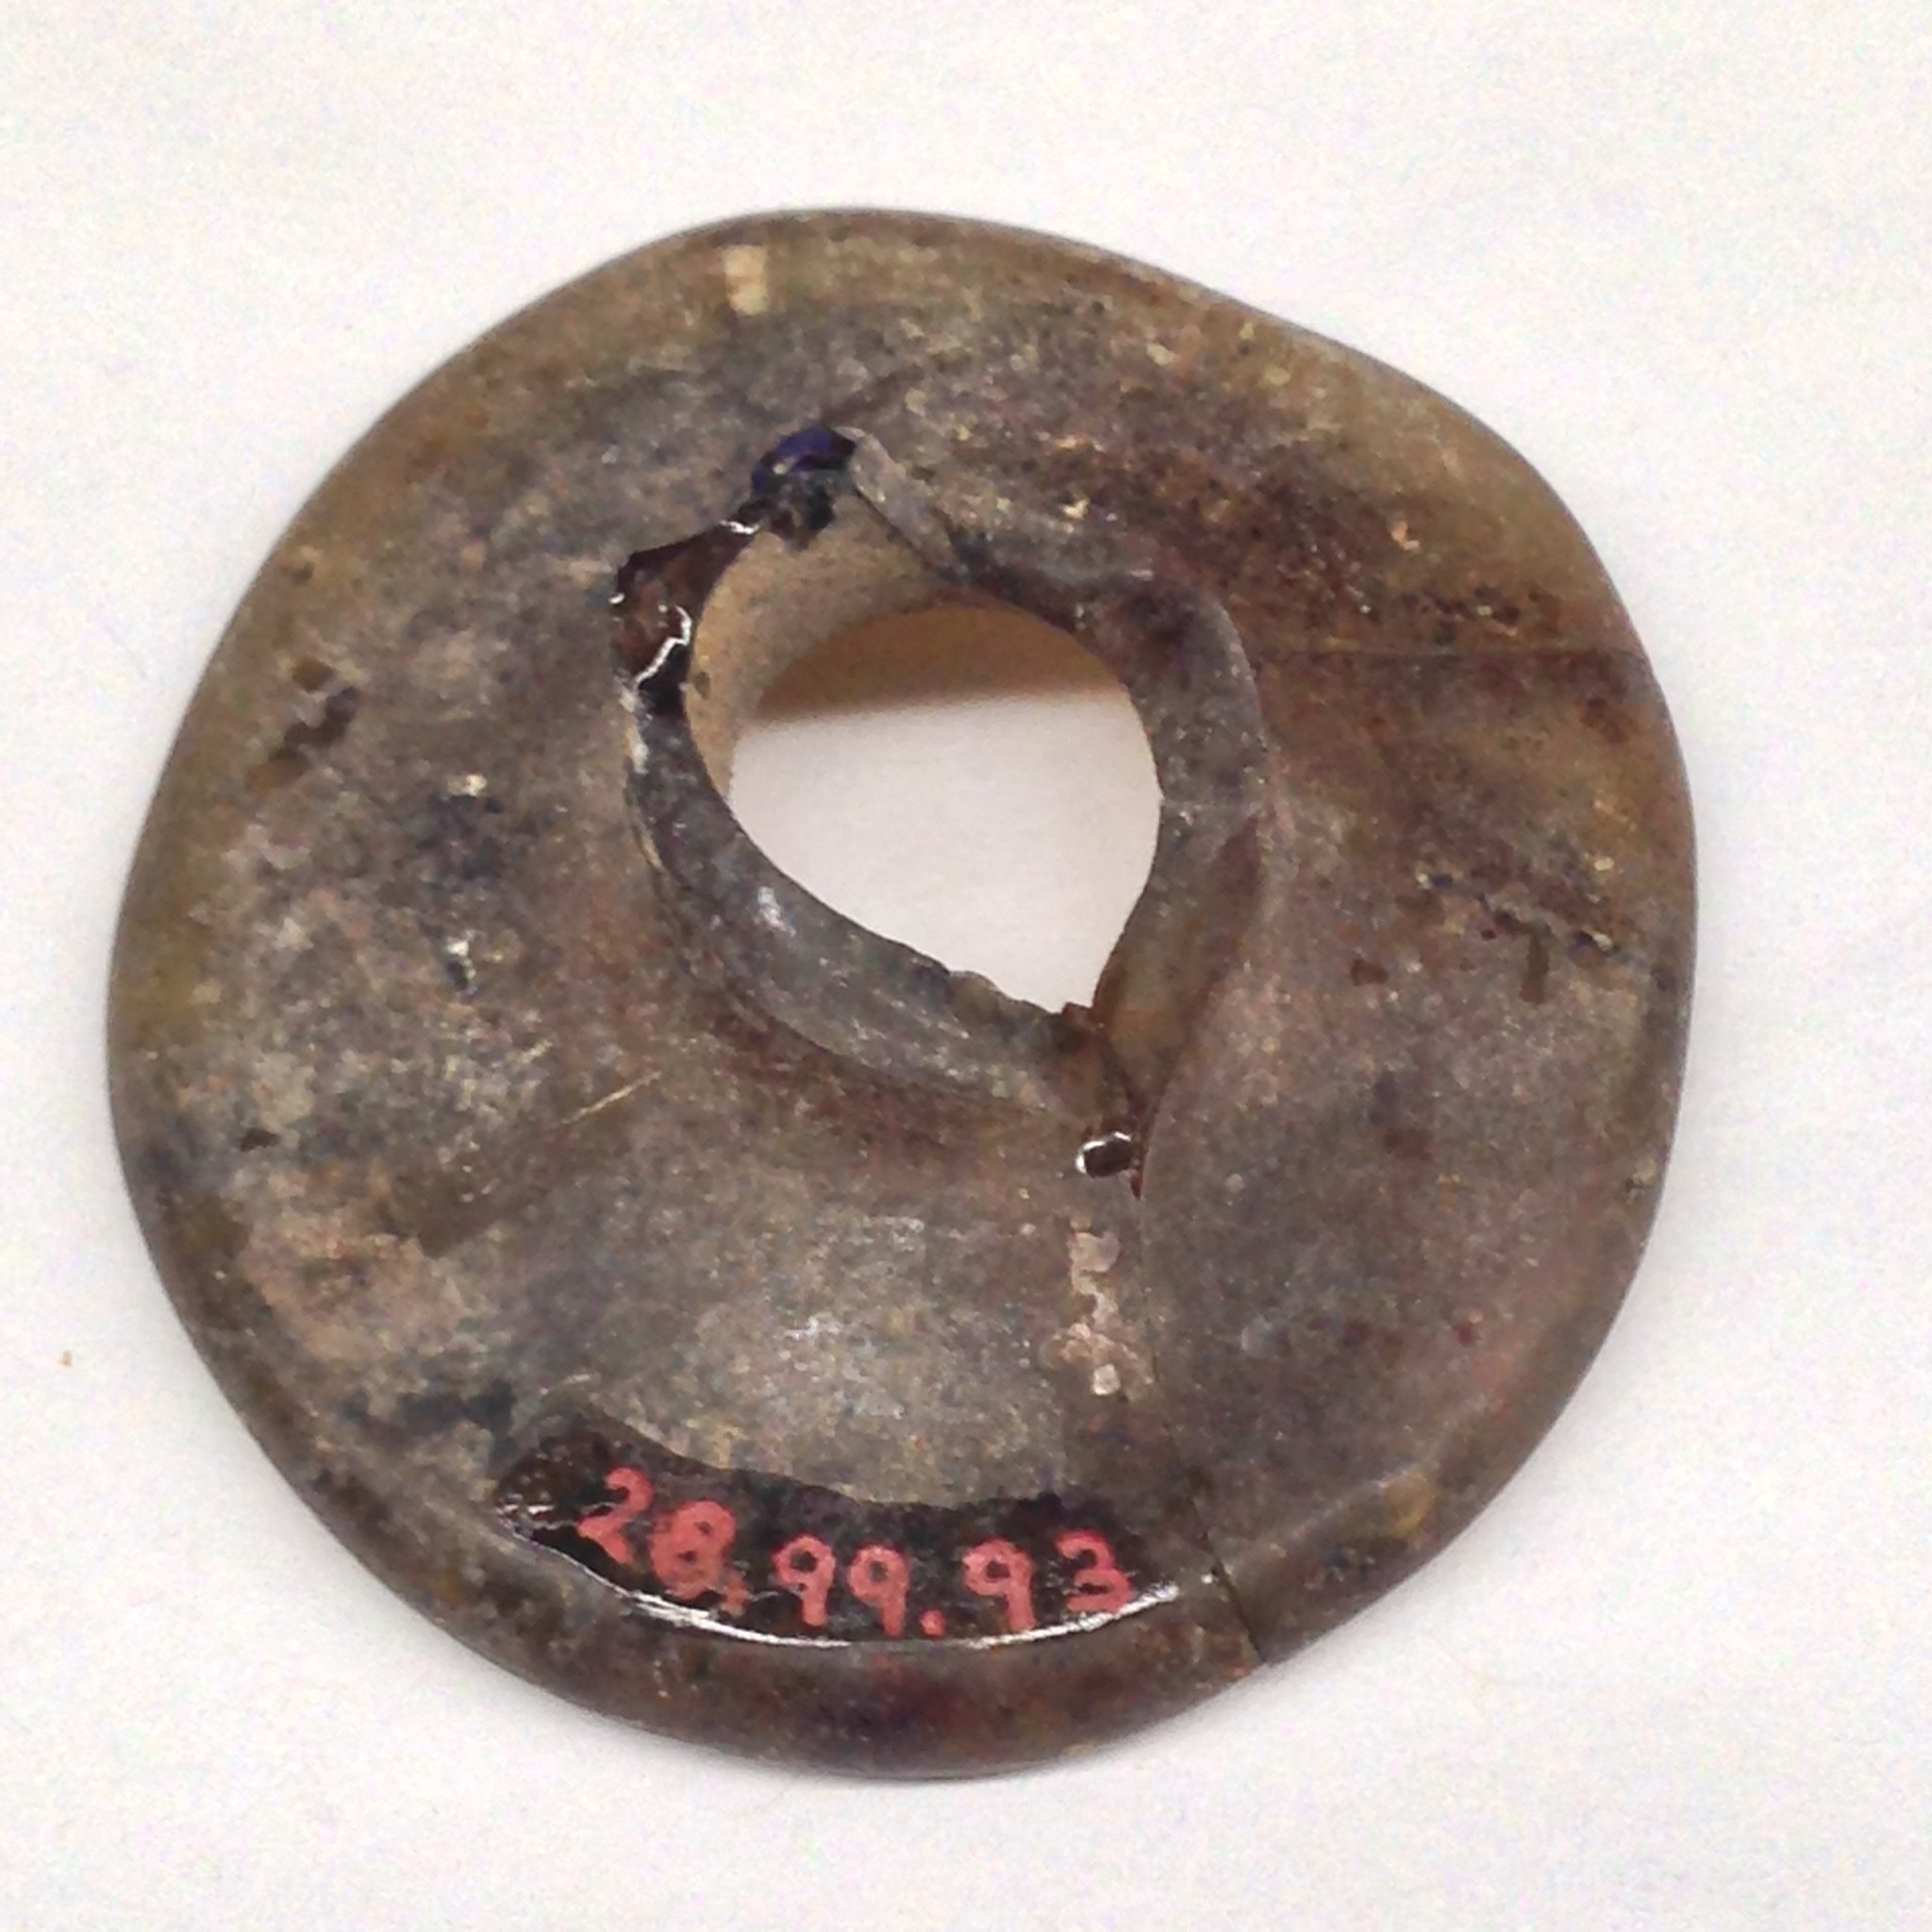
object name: fragment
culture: european or middle eastern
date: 1150-1250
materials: ceramic, glass